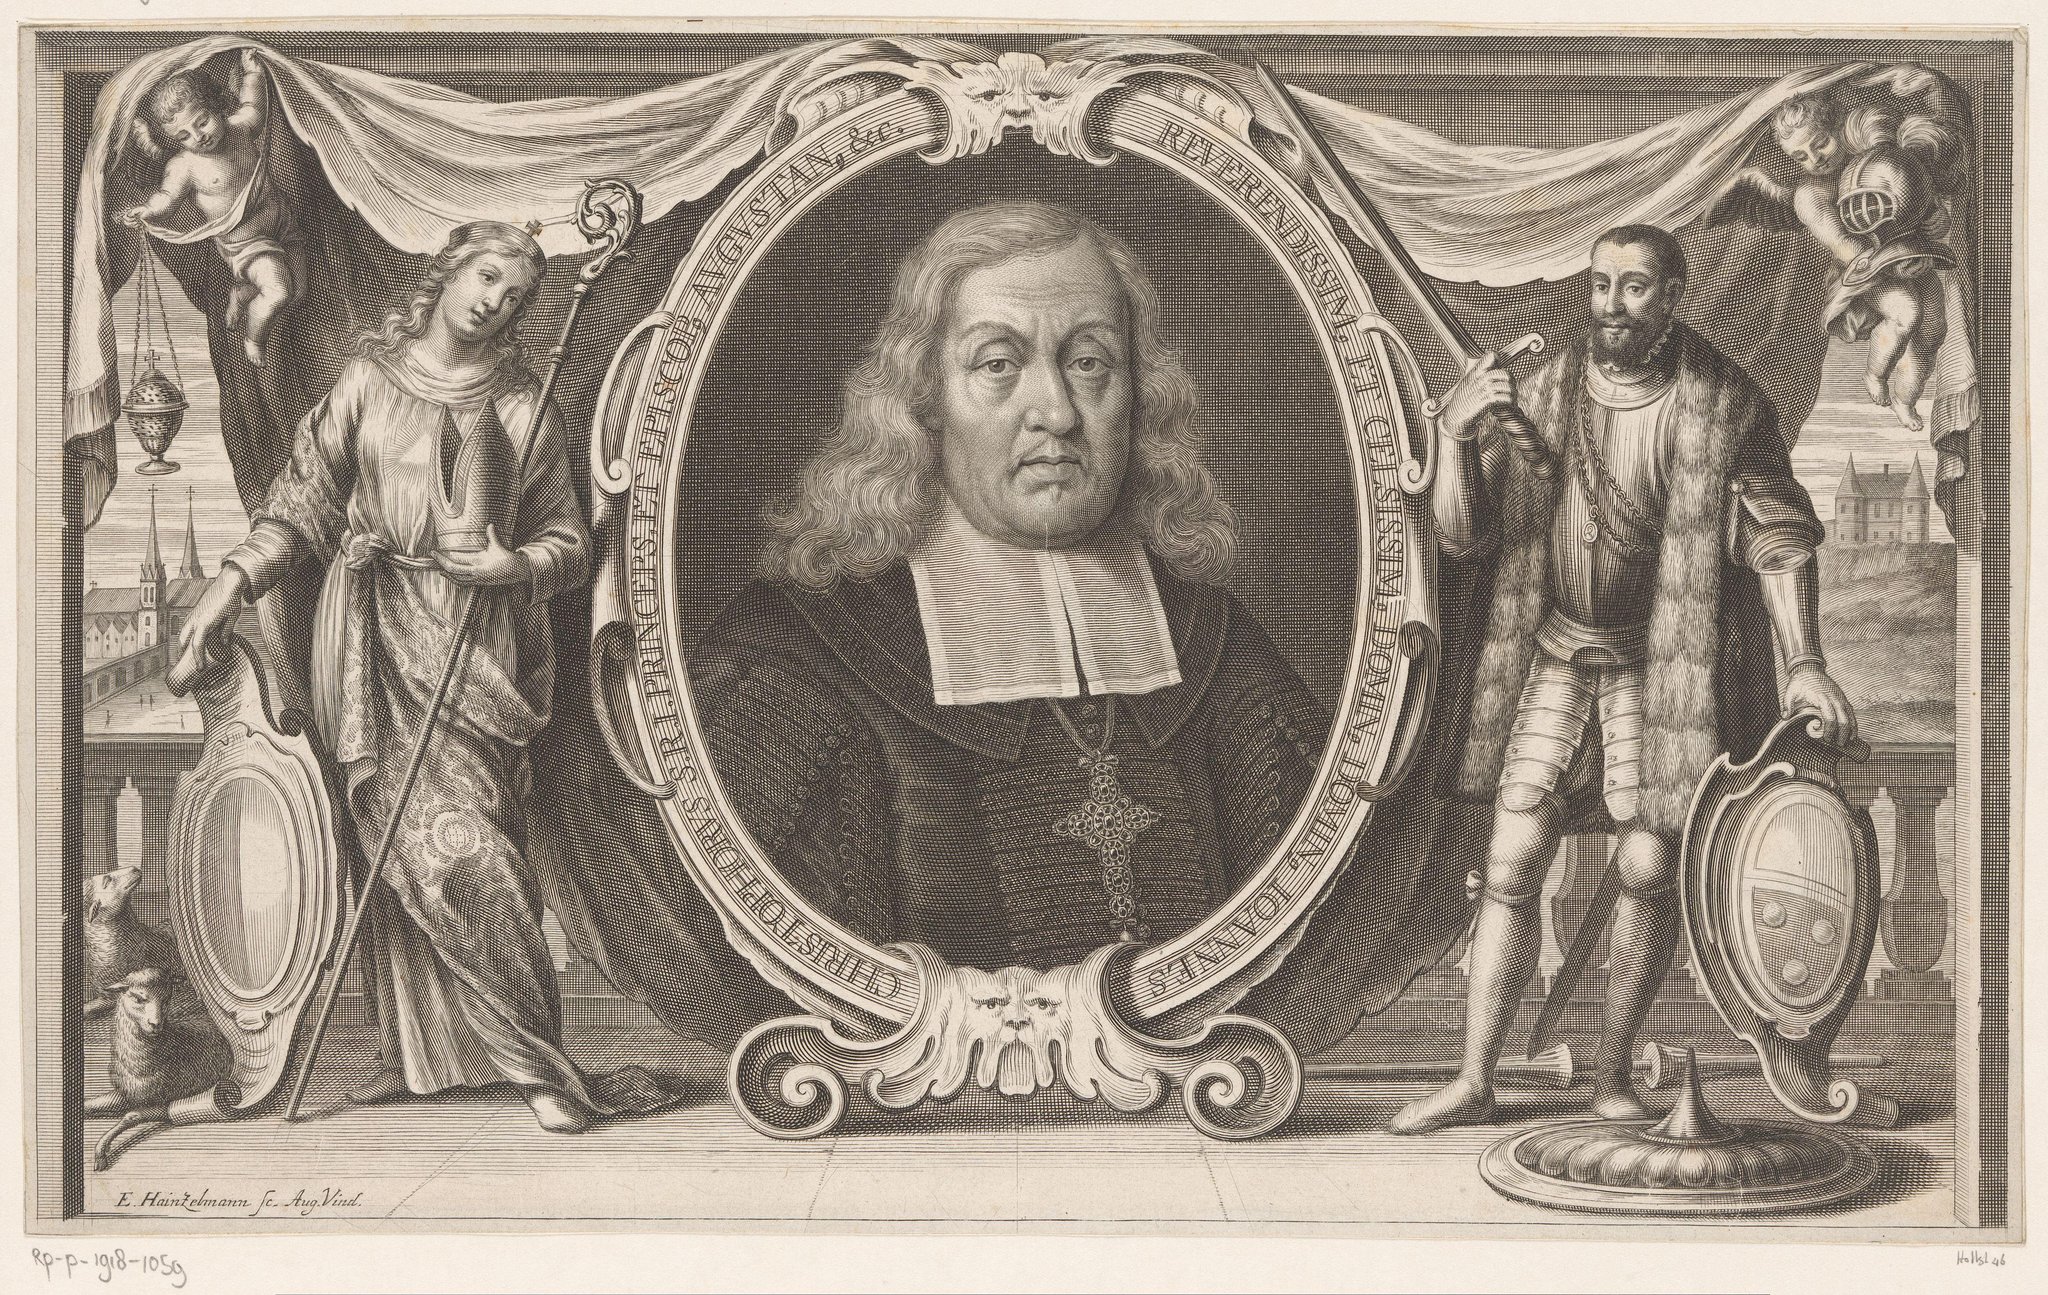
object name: print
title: Portret van Johann Christoph Adelmann von Adelmannsfelden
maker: elias hainzelmann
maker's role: artist, print maker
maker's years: 1640-1693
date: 1655-1693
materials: paper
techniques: engraving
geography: augsburg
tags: city-view in general; 'veduta', insignia of bishop, e.g. mitre, crozier, historical persons, lamb, symbols, allegories of war; 'guerra' (ripa), armorial bearing, heraldry, augsburg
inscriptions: collector's mark: Lugt 2612, collector's mark: Lugt 2233